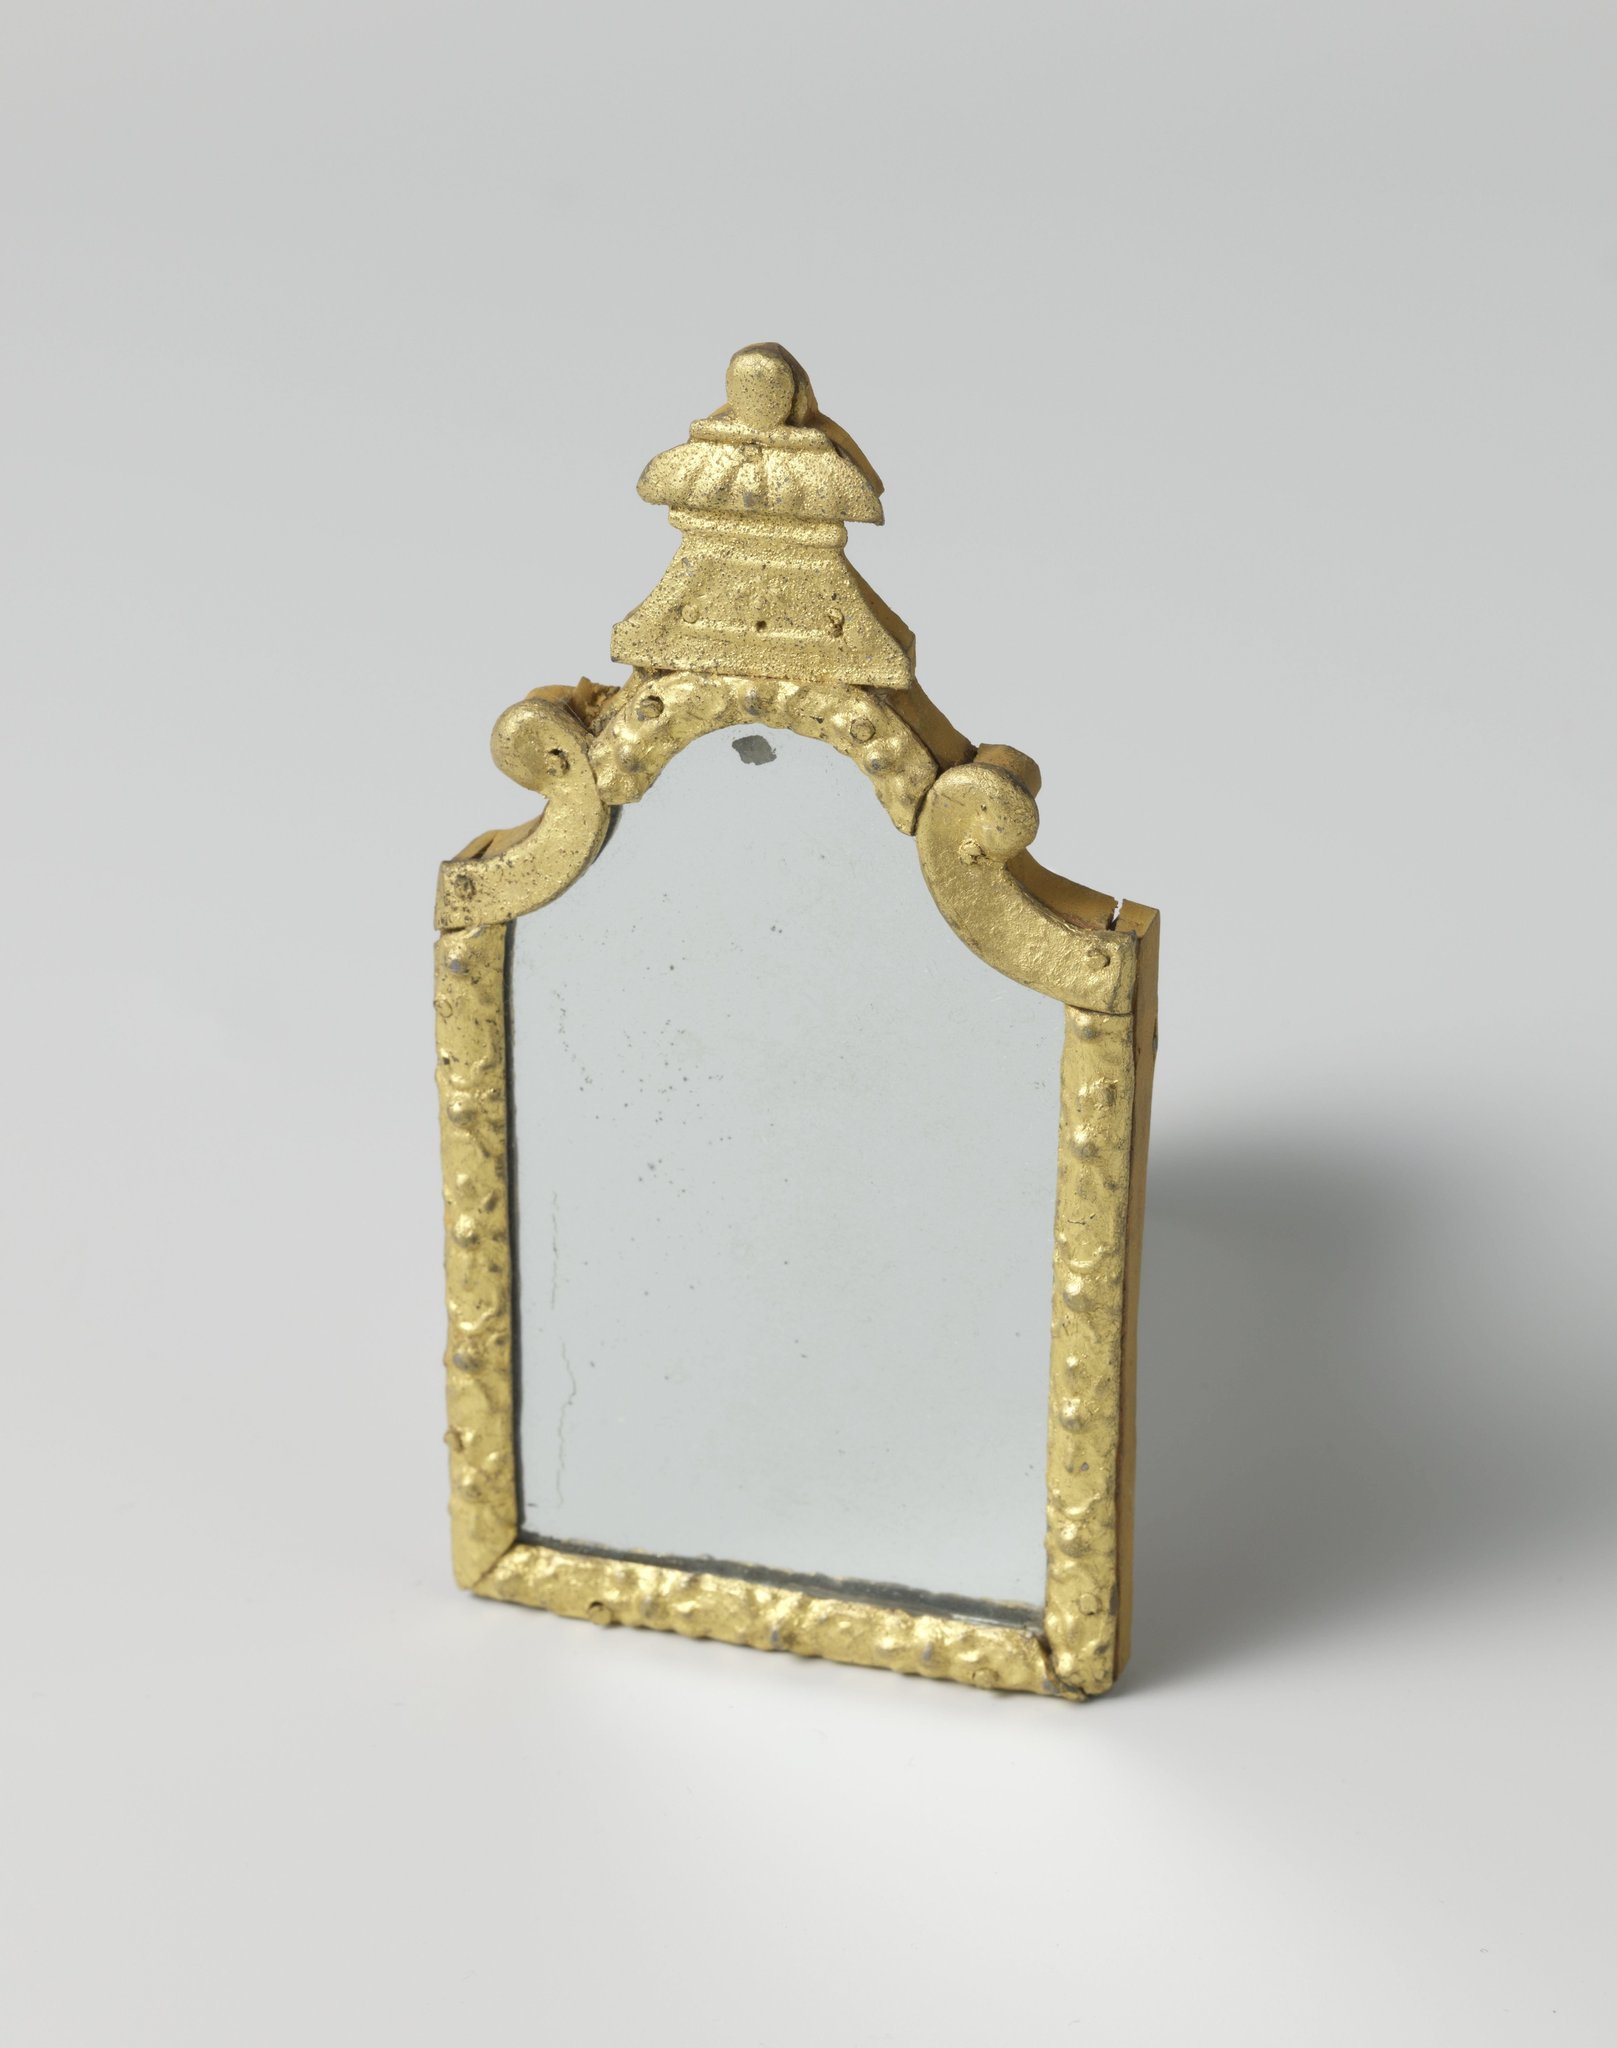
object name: miniature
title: Spiegel in een vergulde lijst met bloemmotieven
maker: Anonymous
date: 1740-1760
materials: amalgam, glass, metal alloy, wood, wool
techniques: gilding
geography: amsterdam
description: Twee spiegels, gevat in een lijst van verguld metaal (tin legering) en gemonteerd op lichtbruin geverfd hout. De gegoten lijst is gedecoreerd met bloemmotieven en een piramidaal opzetstuk met lobben en knop. Tussen het spiegelglas en de houten achterwand bevindt zich een stukje stof.